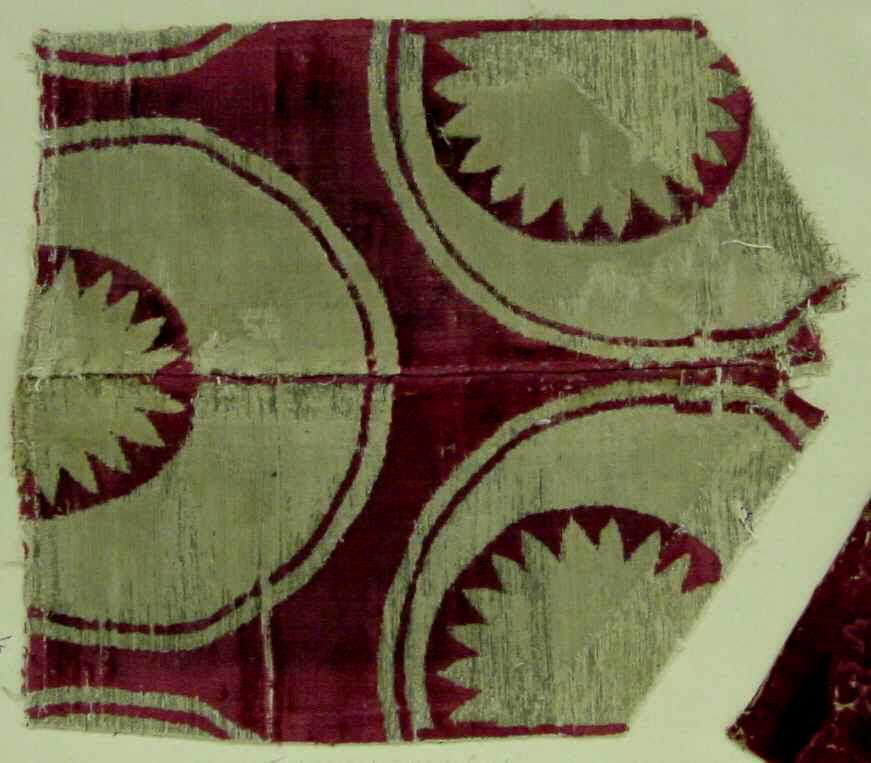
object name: textile fragment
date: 1500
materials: metal thread, silk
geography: turkey